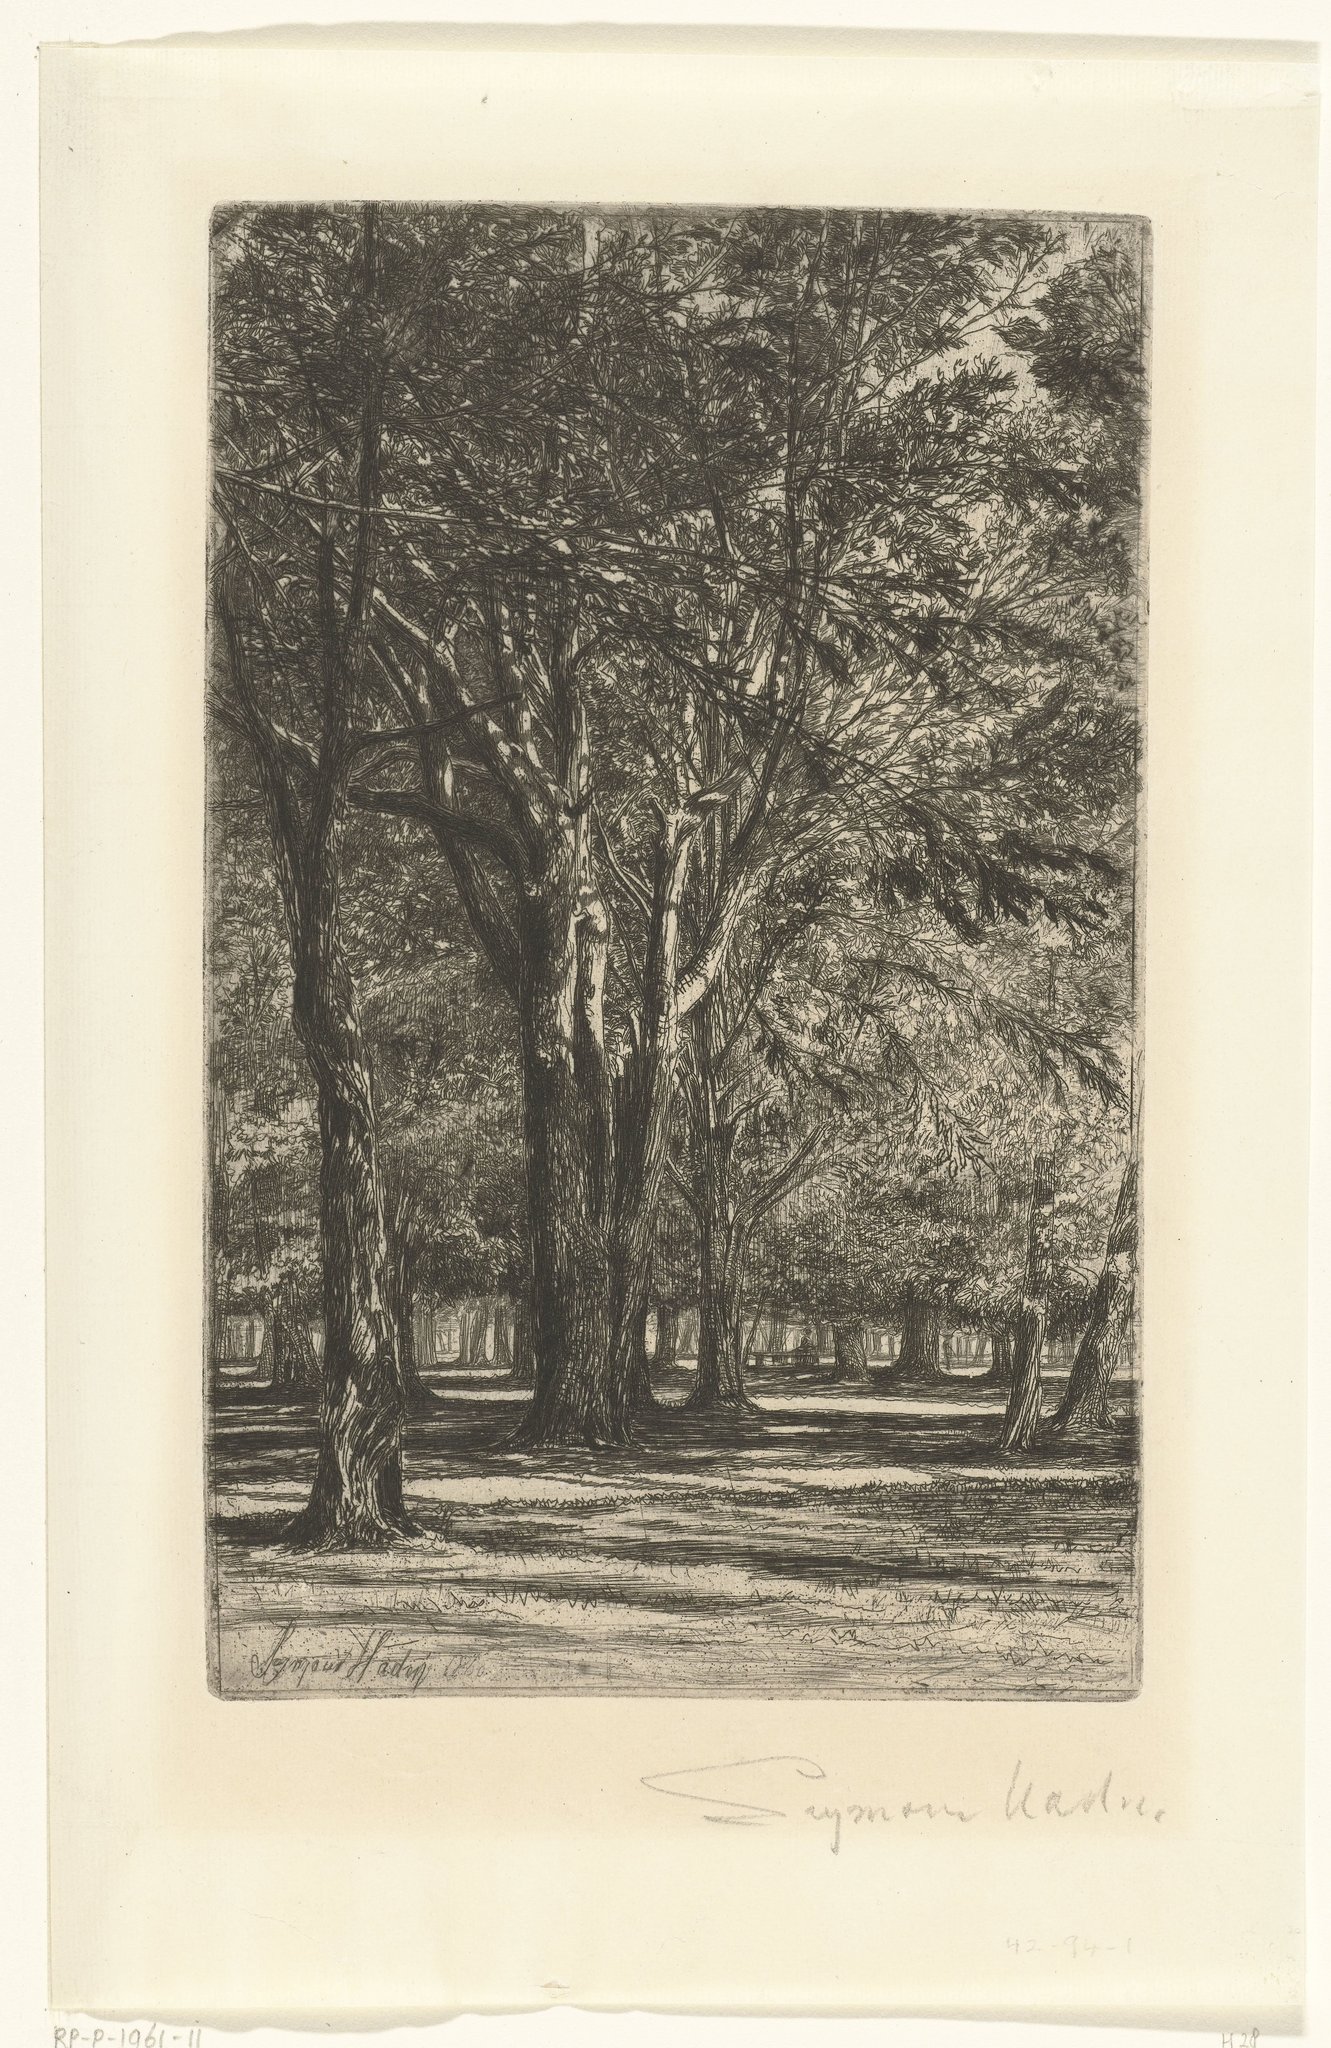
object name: print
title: Kensington Gardens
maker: francis seymour-haden (sir)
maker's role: print maker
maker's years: 1818-1910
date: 1860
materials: paper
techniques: drypoint, etching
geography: england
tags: trees, public gardens, park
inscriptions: collector's mark: Lugt 2228, signature: ‘Seymour Haden’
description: Deze derde staat is gepubliceerd in "A selection of etchings bij The Etching Club", 1865. Botke, K.